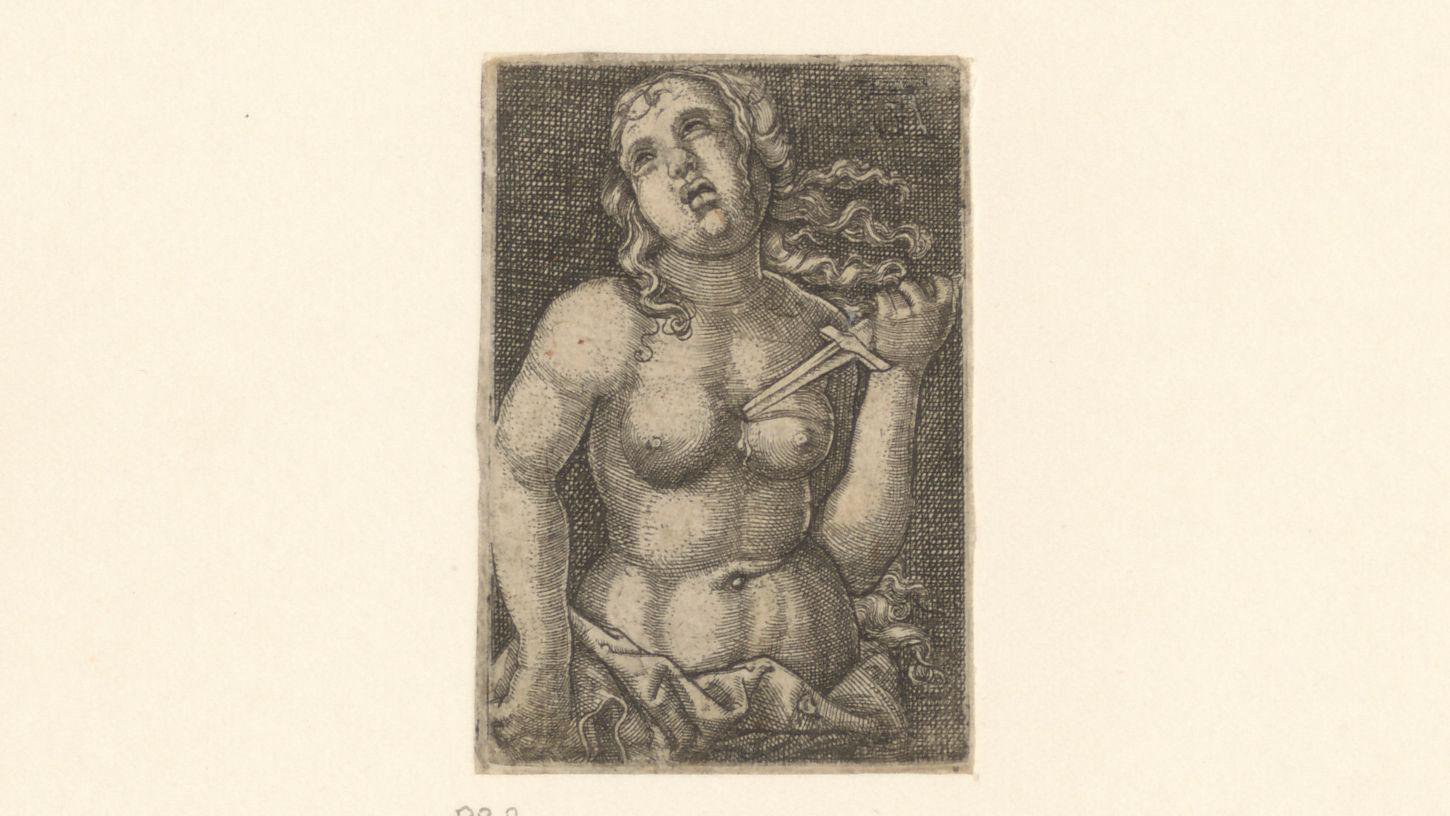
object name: print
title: Lucretia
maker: Anonymous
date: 1525-1575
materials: paper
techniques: engraving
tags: (story of) lucretia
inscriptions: collector's mark: Lugt 2228